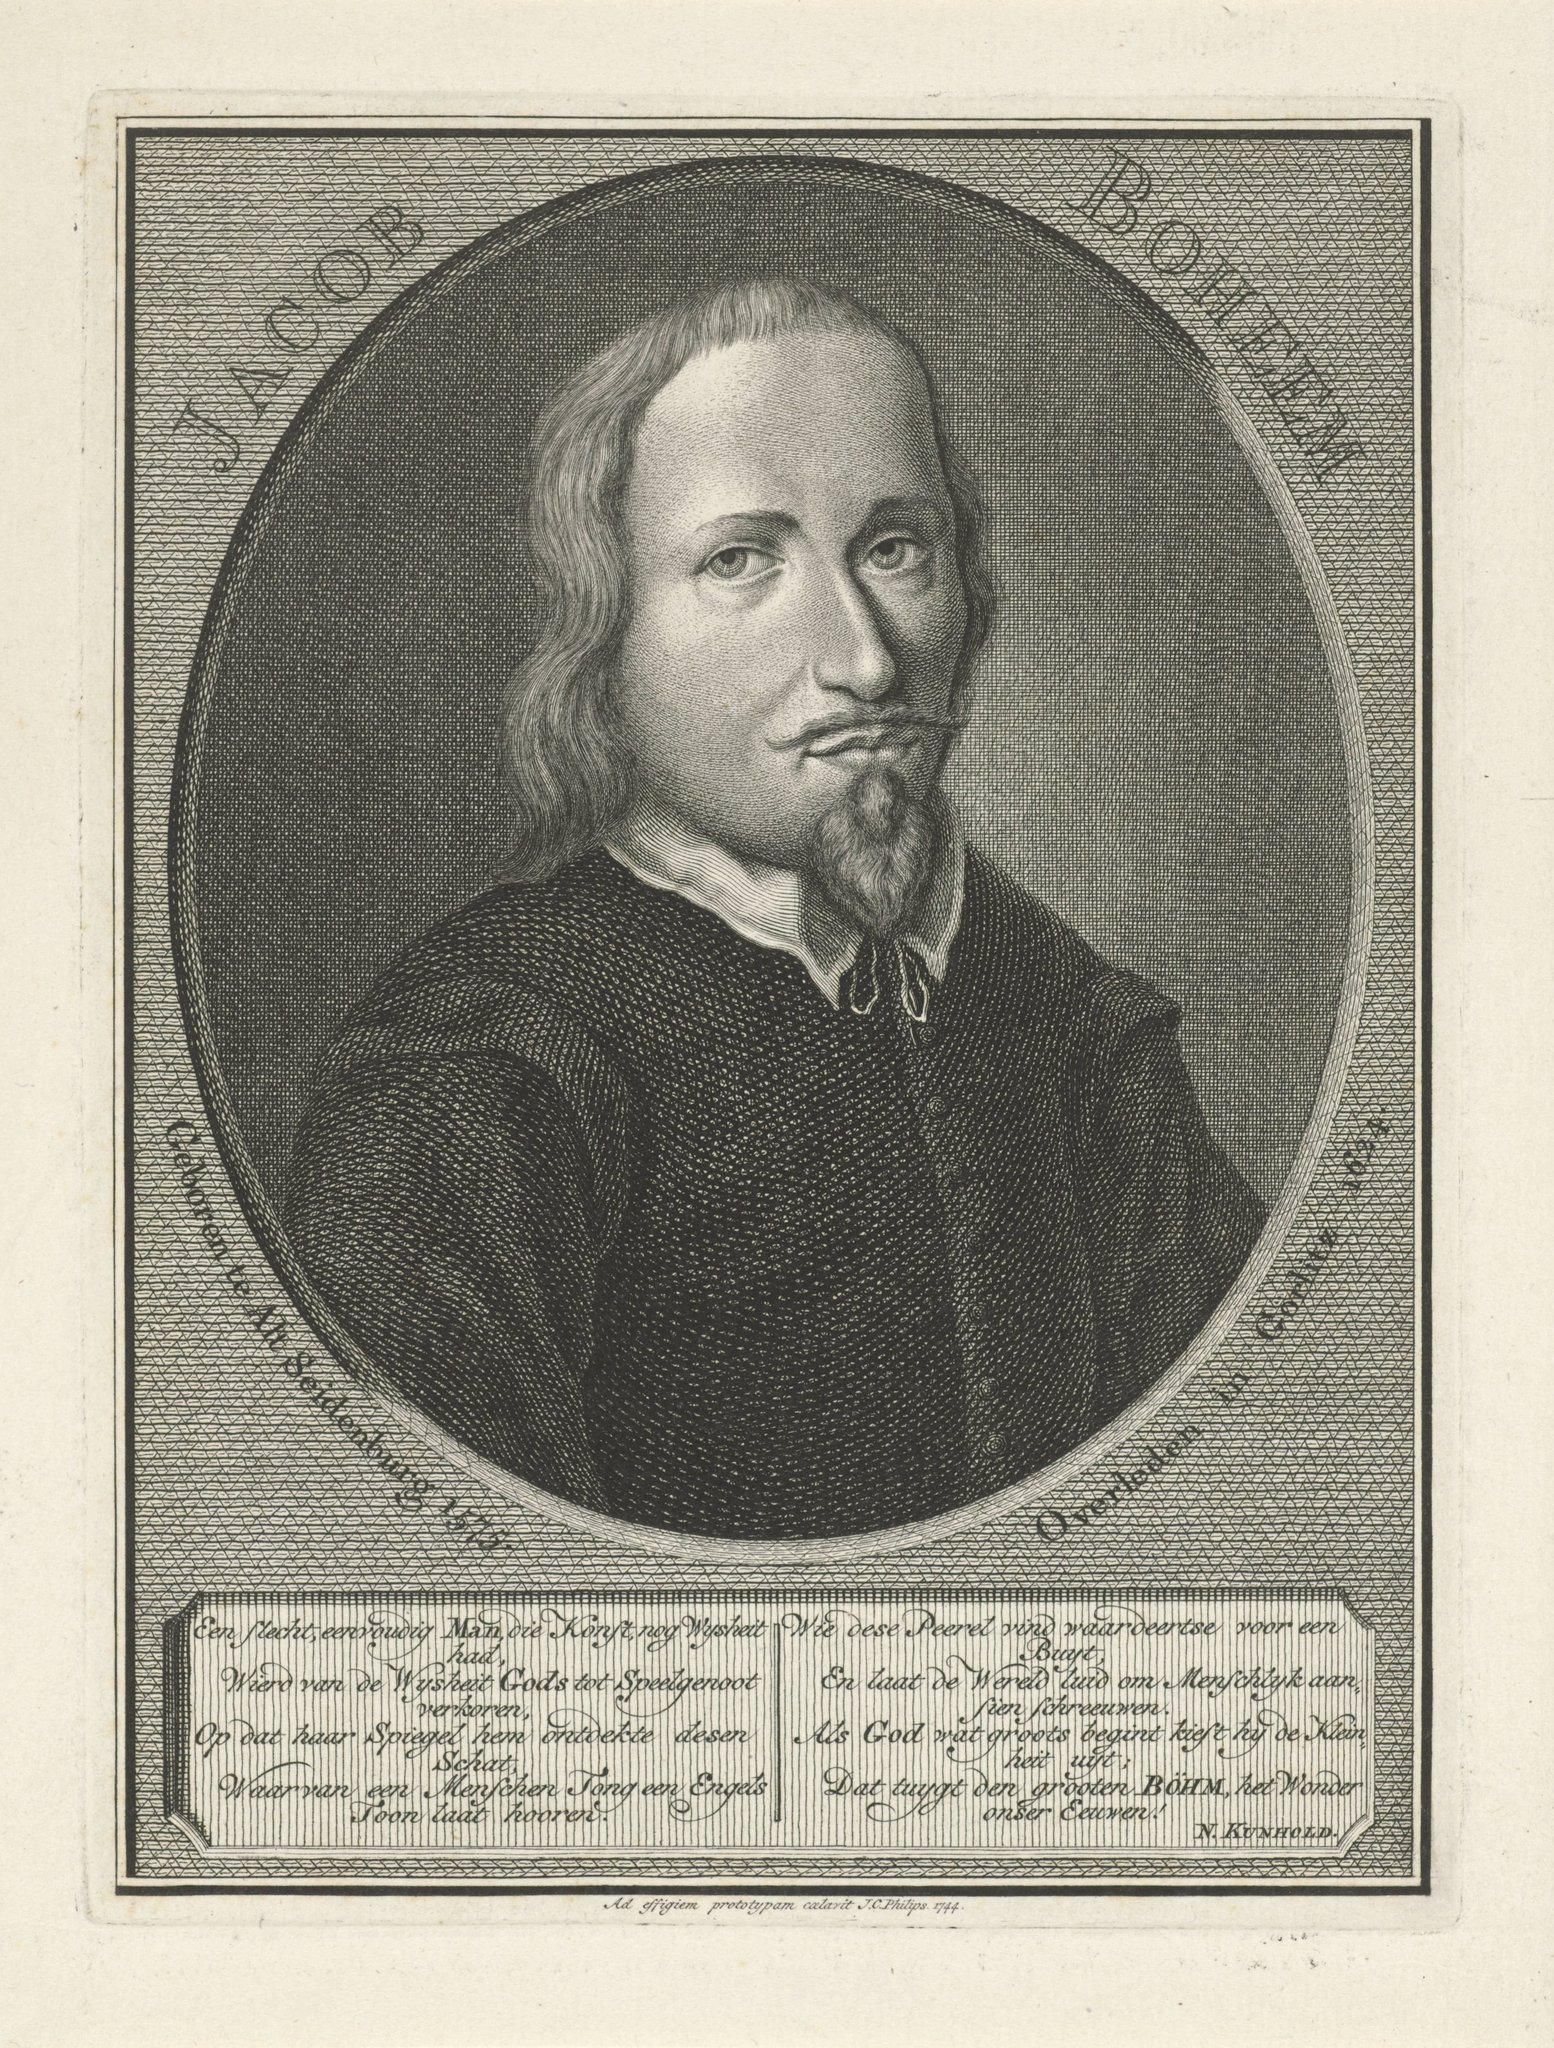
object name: print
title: Portret van de filosoof Jakob Böhme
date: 1744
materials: paper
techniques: engraving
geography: amsterdam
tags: filosoof, jakob böhme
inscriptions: collector's mark: Lugt 2228, collector's mark: Lugt 240